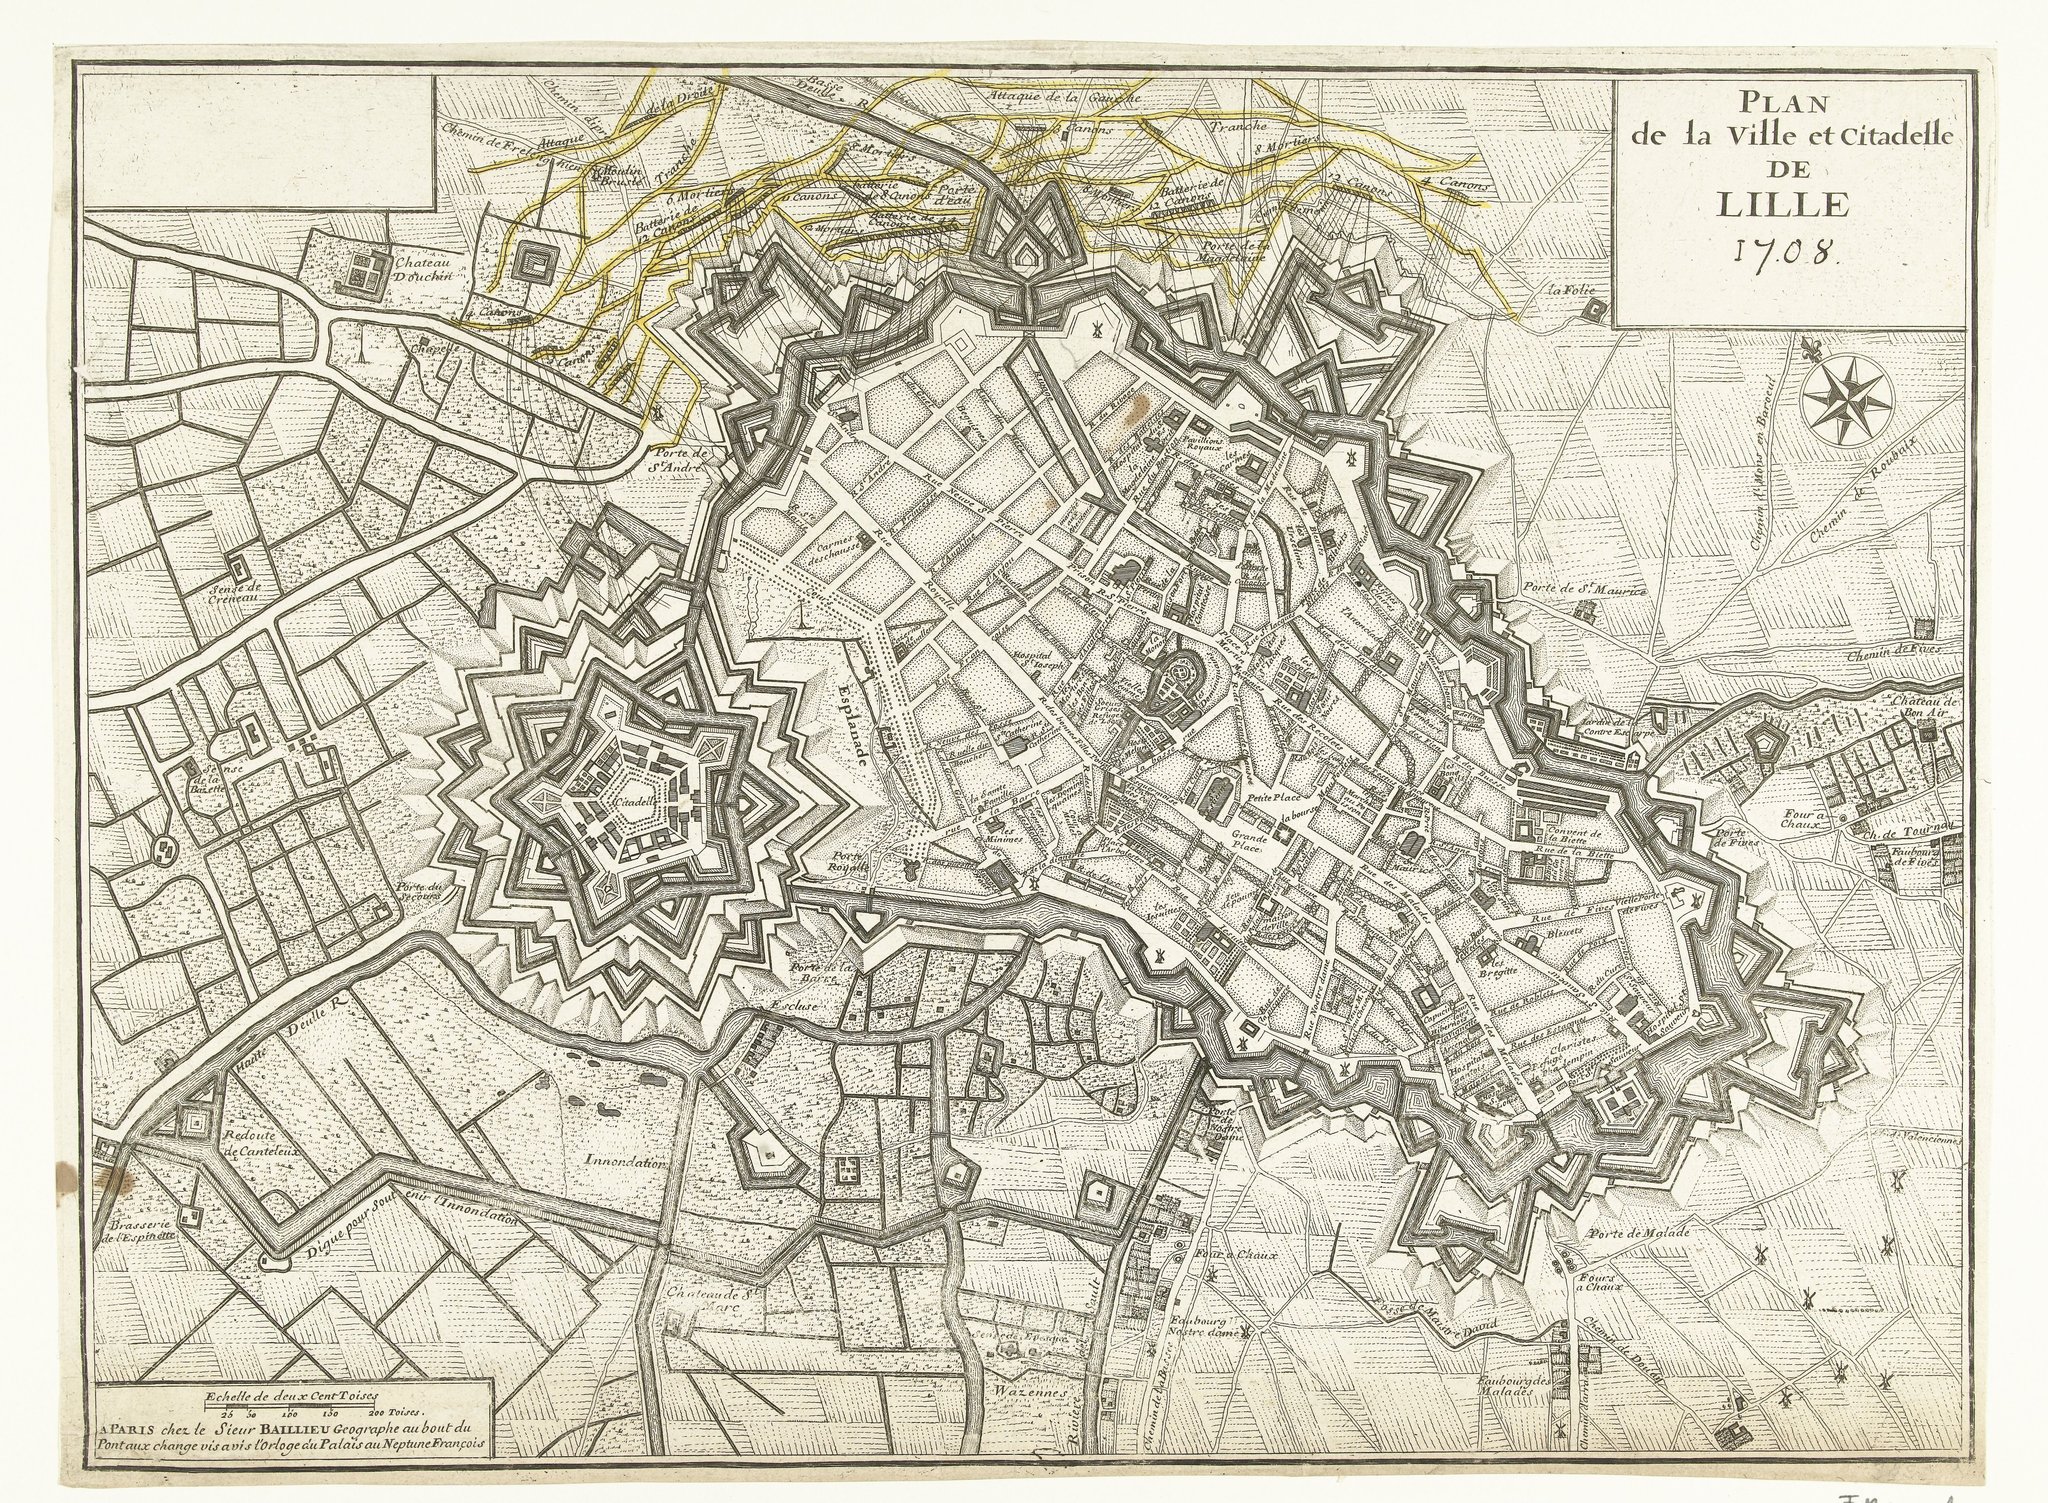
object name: print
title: Plan de la Ville et Citadelle de Lille [1708]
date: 1708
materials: paper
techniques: etching, hand coloring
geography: france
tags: johan willem friso (prins van oranje-nassau), paris, vienna, eugenius van savoye, siege, position war, maps of cities, lille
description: Plattegrond van het beleg vanaf 22 augustus van Rijssel (Lille) door de Geallieerden onder prins Eugenius van Savoye en prins Johan Willem Friso. De loopgraven aan de noordzijde van de stad zijn ingekleurd.